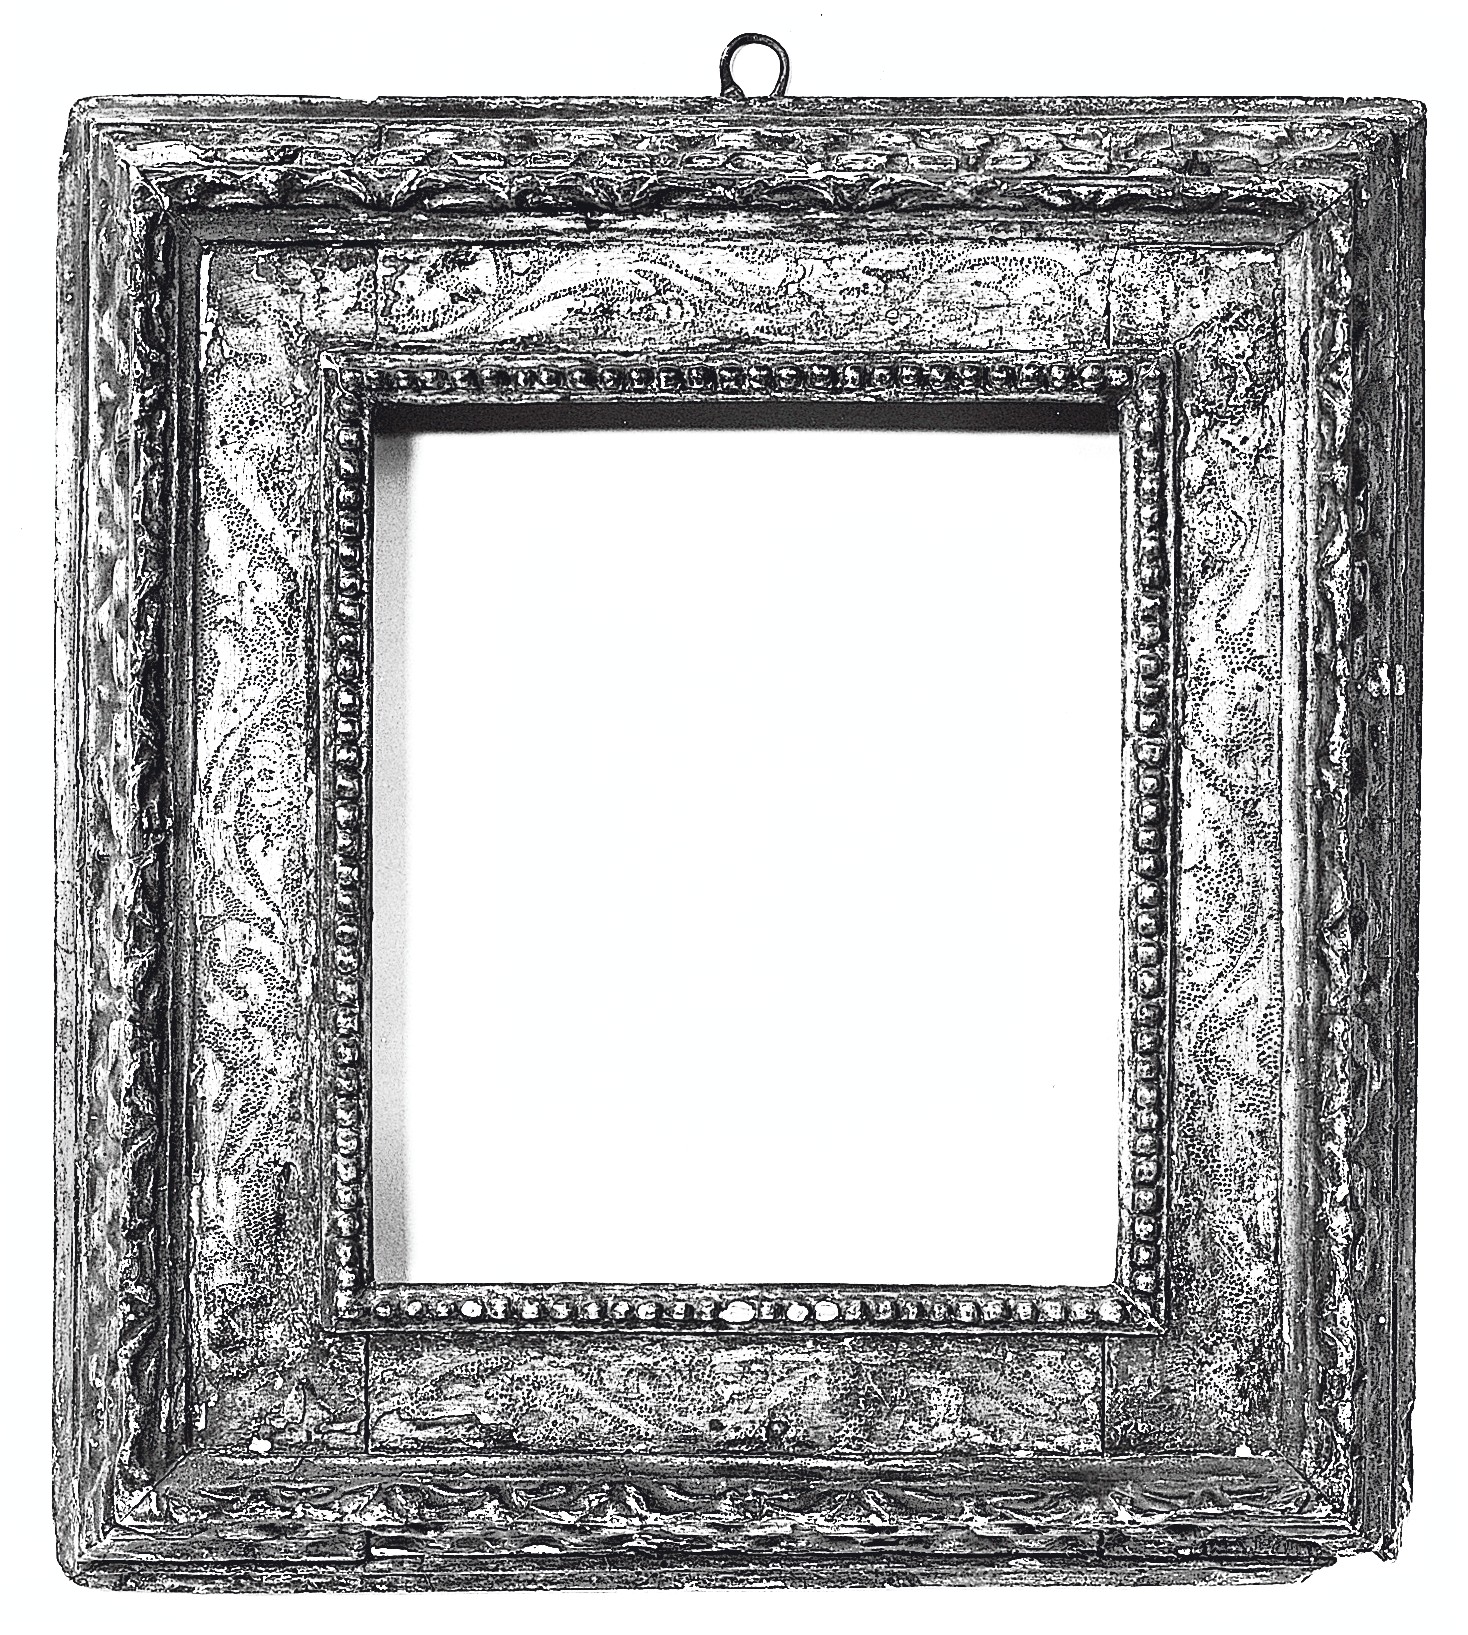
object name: frame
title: Reverse cassetta frame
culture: italian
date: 1634-1666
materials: wood